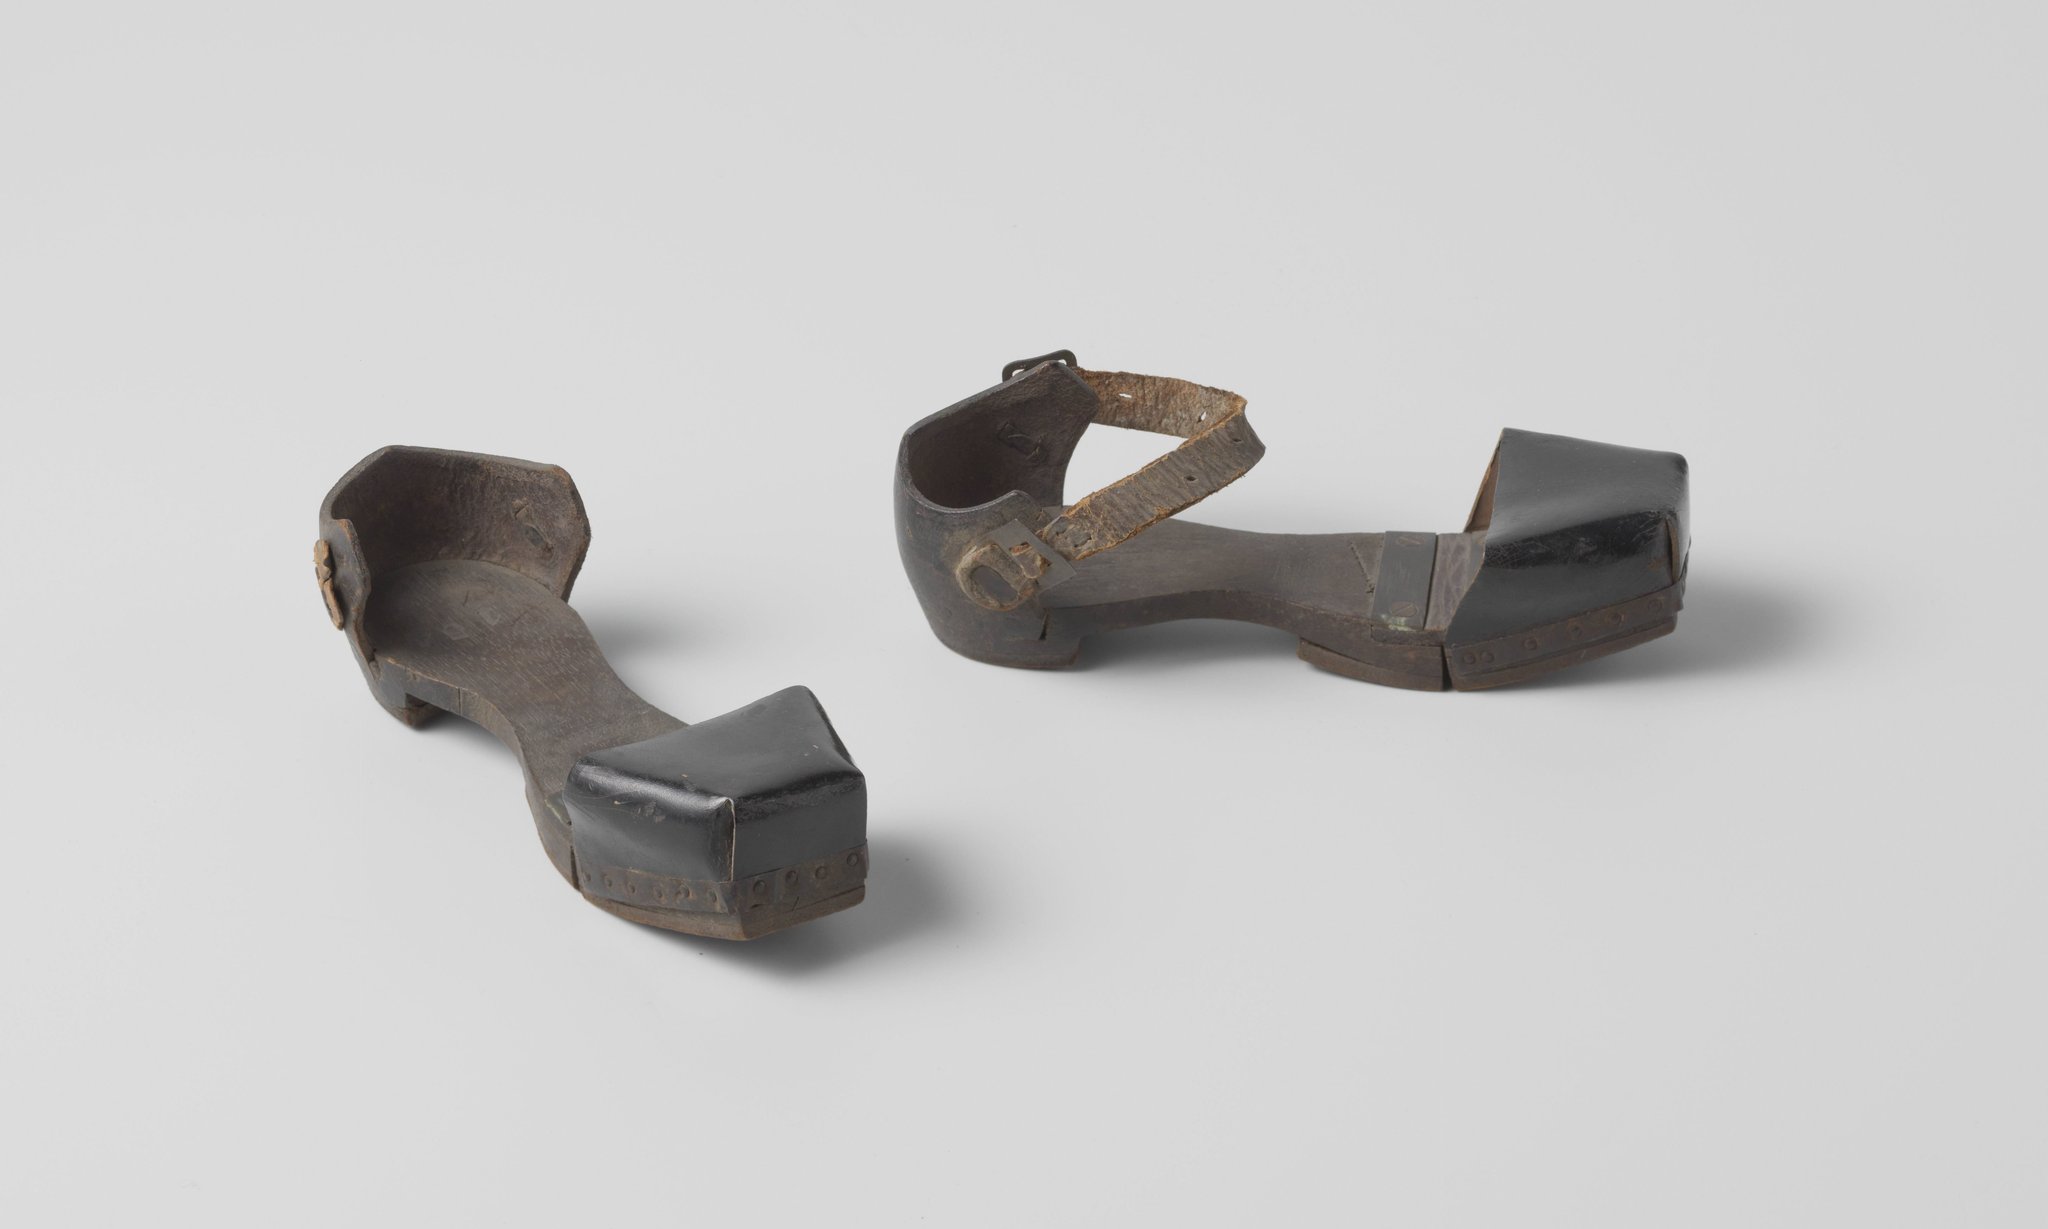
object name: childrenswear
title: Pair of mules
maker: Anonymous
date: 1800-1900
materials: copper, leather, wood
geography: netherlands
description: Schoen of muil met houten zolen die in de buiging van de voet scharniert. Voorzool en hak met leer bekleed, vierkante neus. Hielband en gesp ontbreken. Gemerkt: 154. Kindermodel